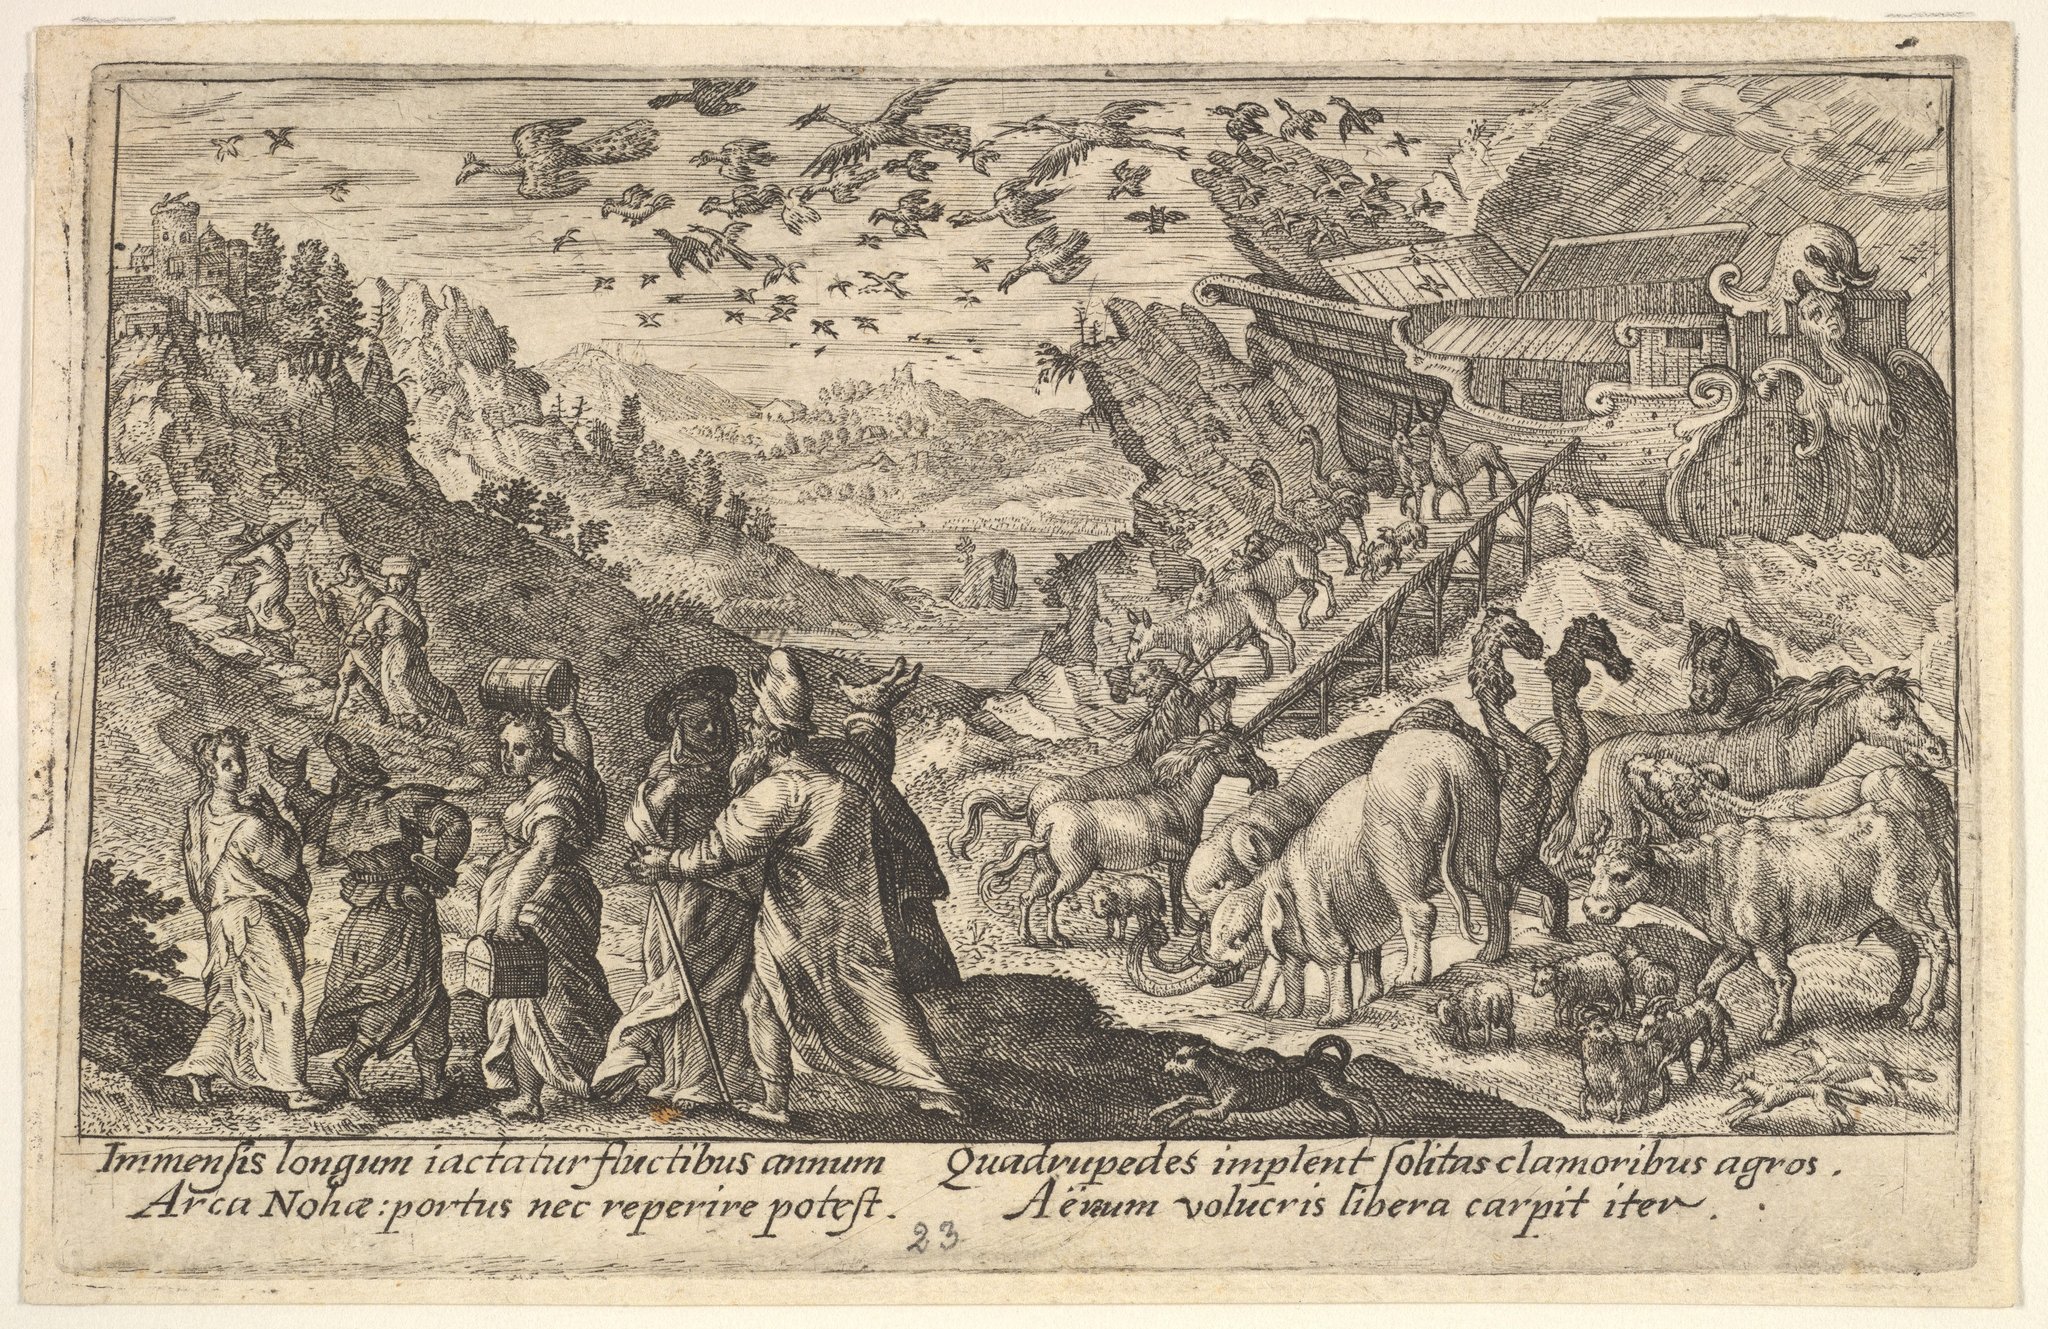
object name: print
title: Noah leaving the ark with his family and animals: at left Noah's family carries supplies, at right animals descend on a ramp from the ark, above birds fly from the ark, from "Liber Genesis"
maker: crispijn de passe the elder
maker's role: artist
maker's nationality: netherlandish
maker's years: 1564-1637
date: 1612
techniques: engraving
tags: animals,birds,men,women,ships